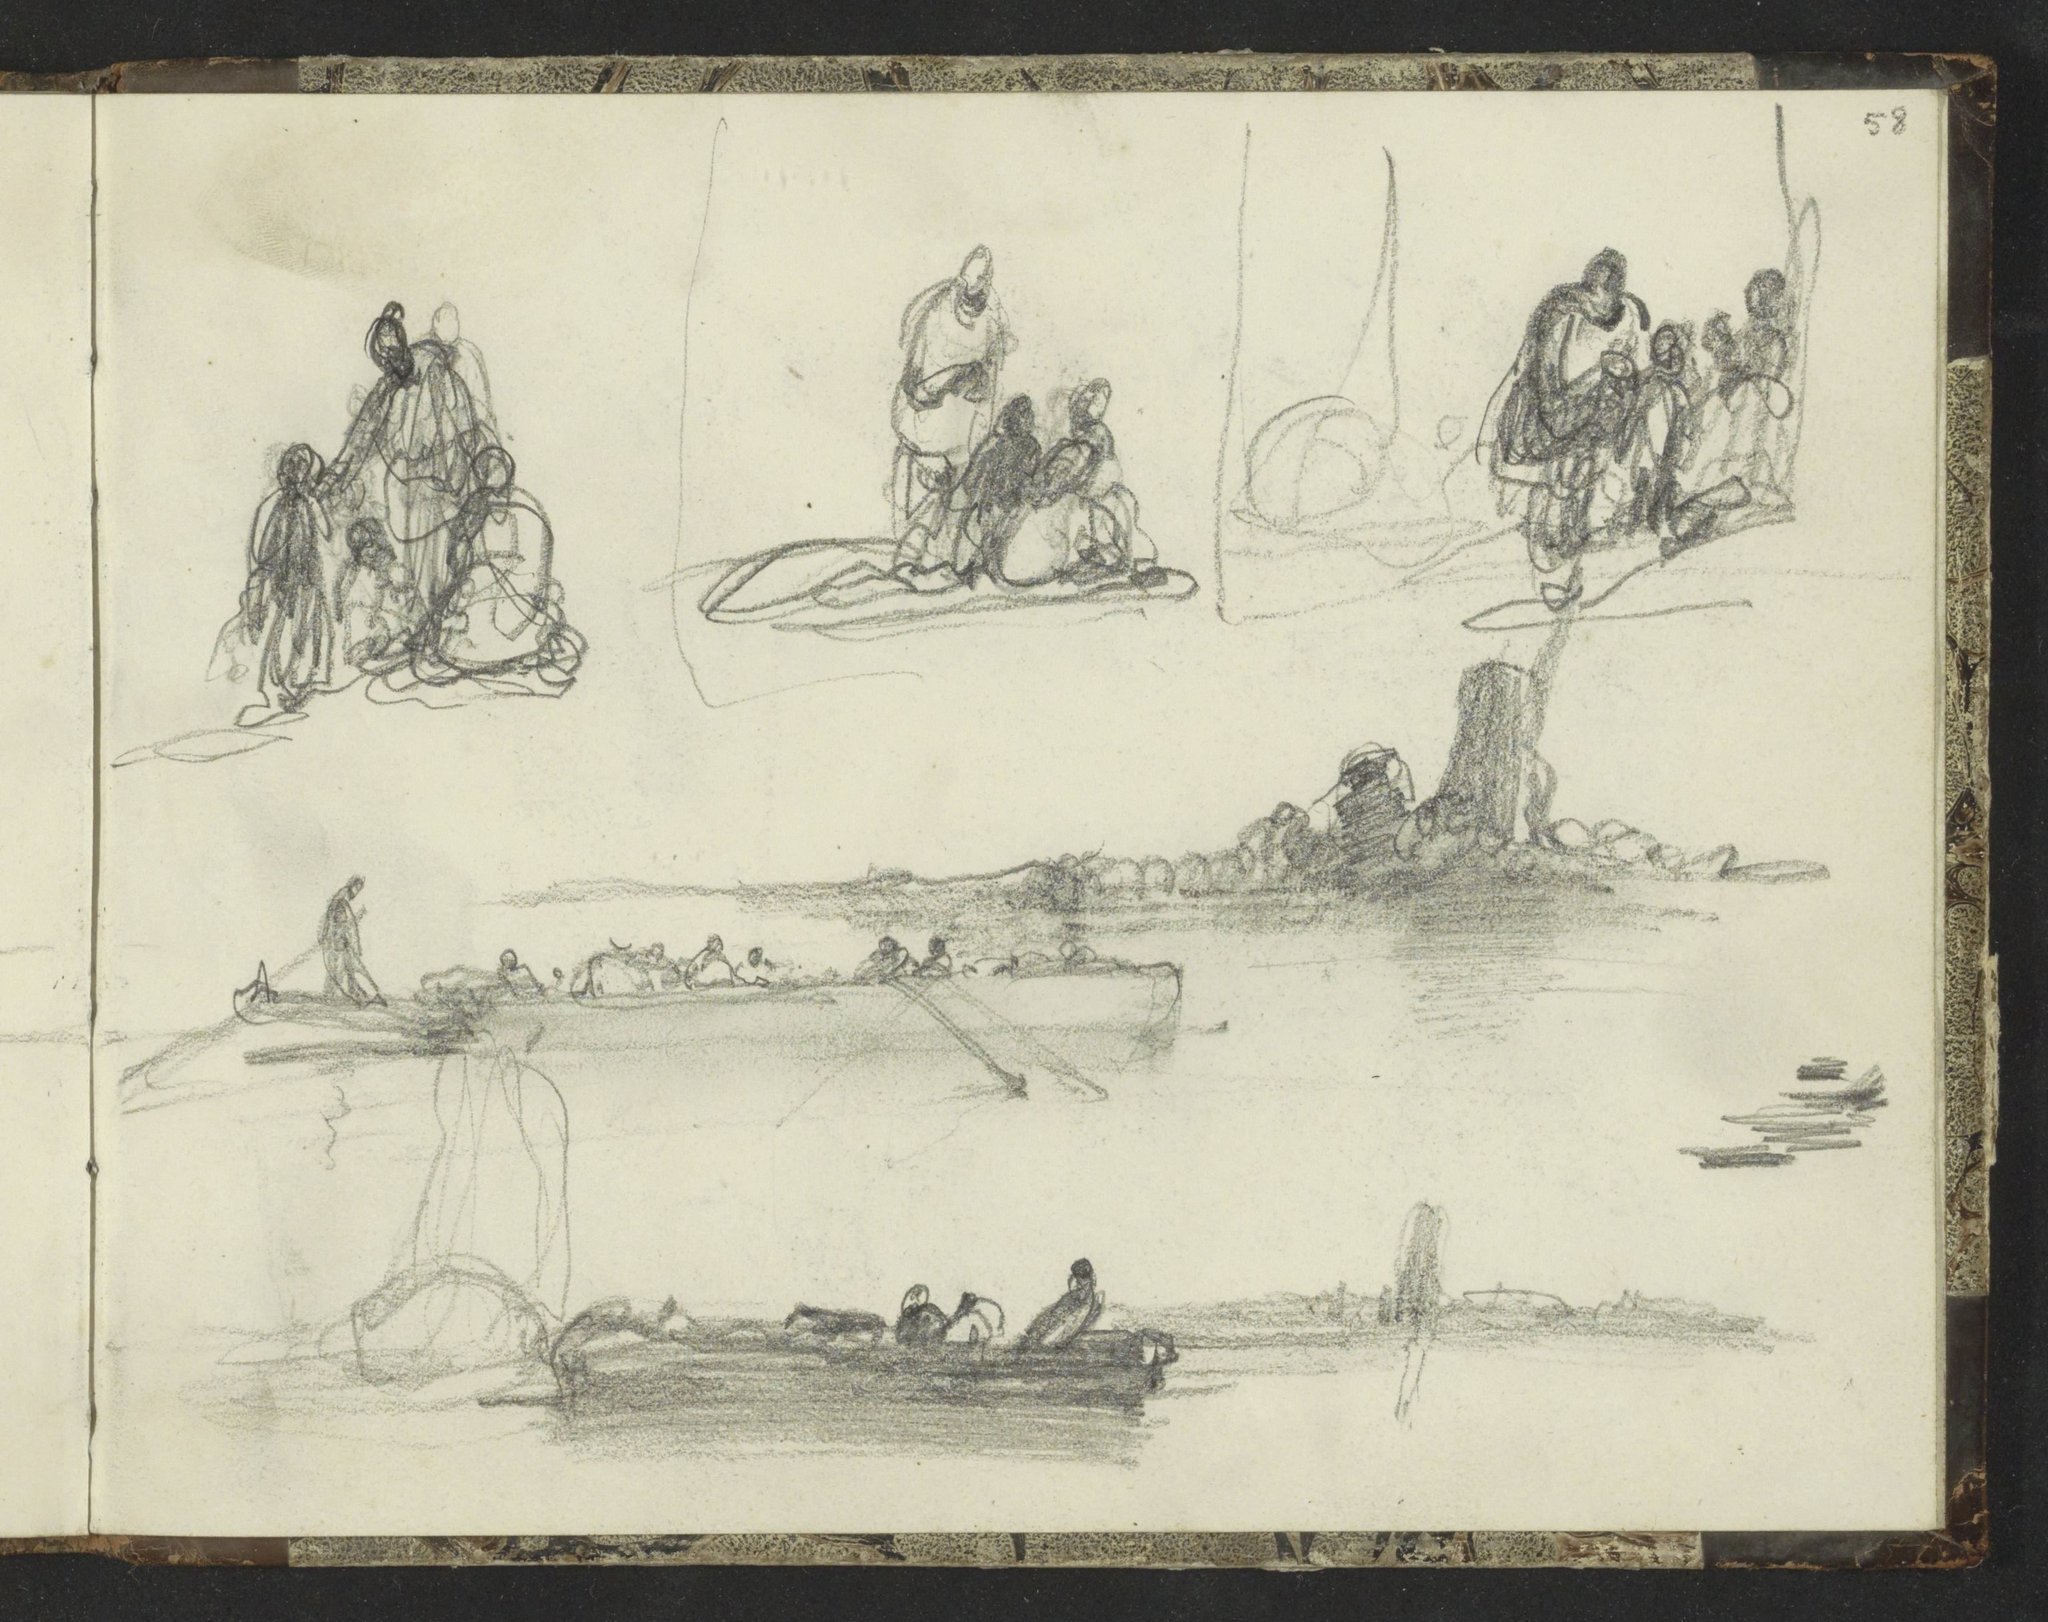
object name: sketchbook leaf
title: Studieblad met figuren op een strand en rivierlandschappen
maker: willem hendrik schmidt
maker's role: draughtsman, painter, print maker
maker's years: 1809-1849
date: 1819-1849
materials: paper, pencil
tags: rowing-boat, canoe, etc., landscapes with waters, waterscapes, seascapes (in the temperate zone) (+ landscape with figures, staffage), beach (+ landscape with figures, staffage)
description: Onder andere twee studies van figuren in roeiboten op het water met op de achtergrond een molen. Blad 58 recto uit een schetsboek met 58 bladen.